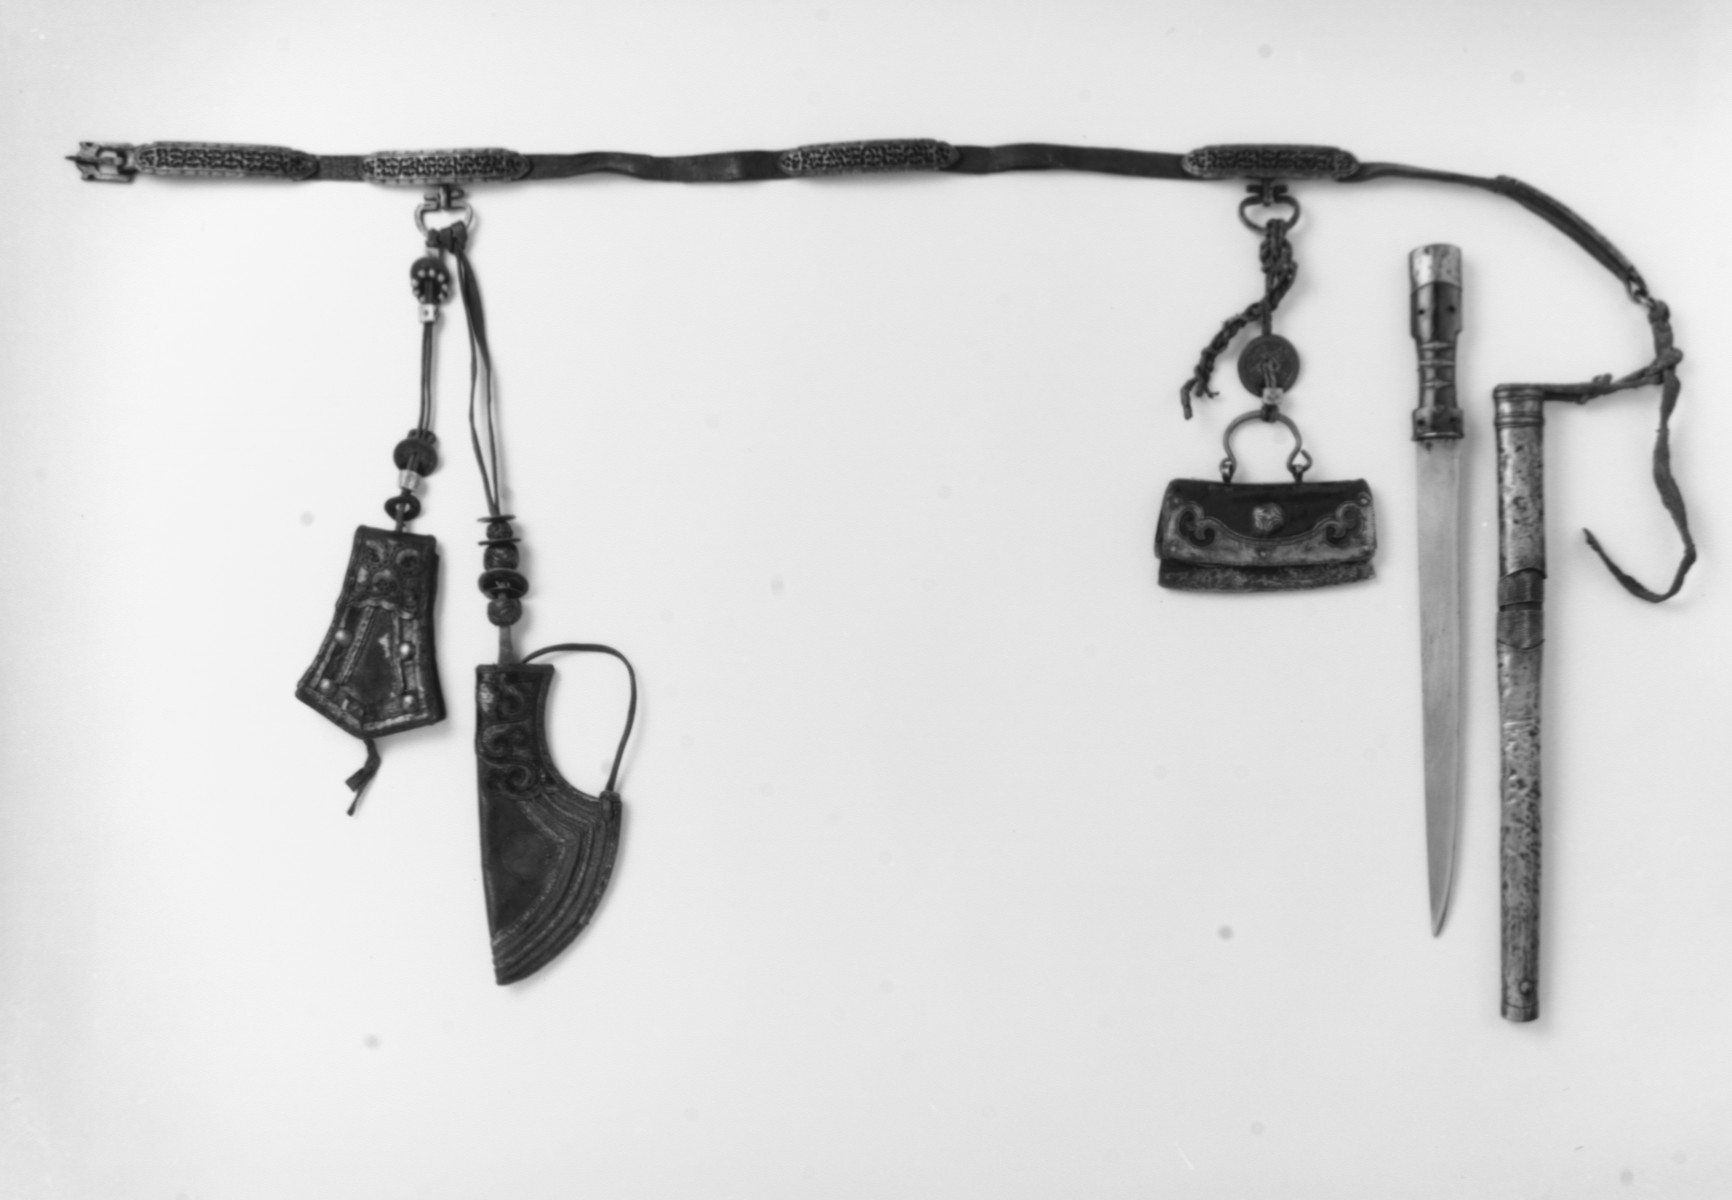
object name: dagger with sheath, belt, and accessory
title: Dagger with Sheath, Belt, and Accessories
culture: tibetan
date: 1801-1900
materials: bone, copper, horn, iron, leather, silver, skin, textile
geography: tibet